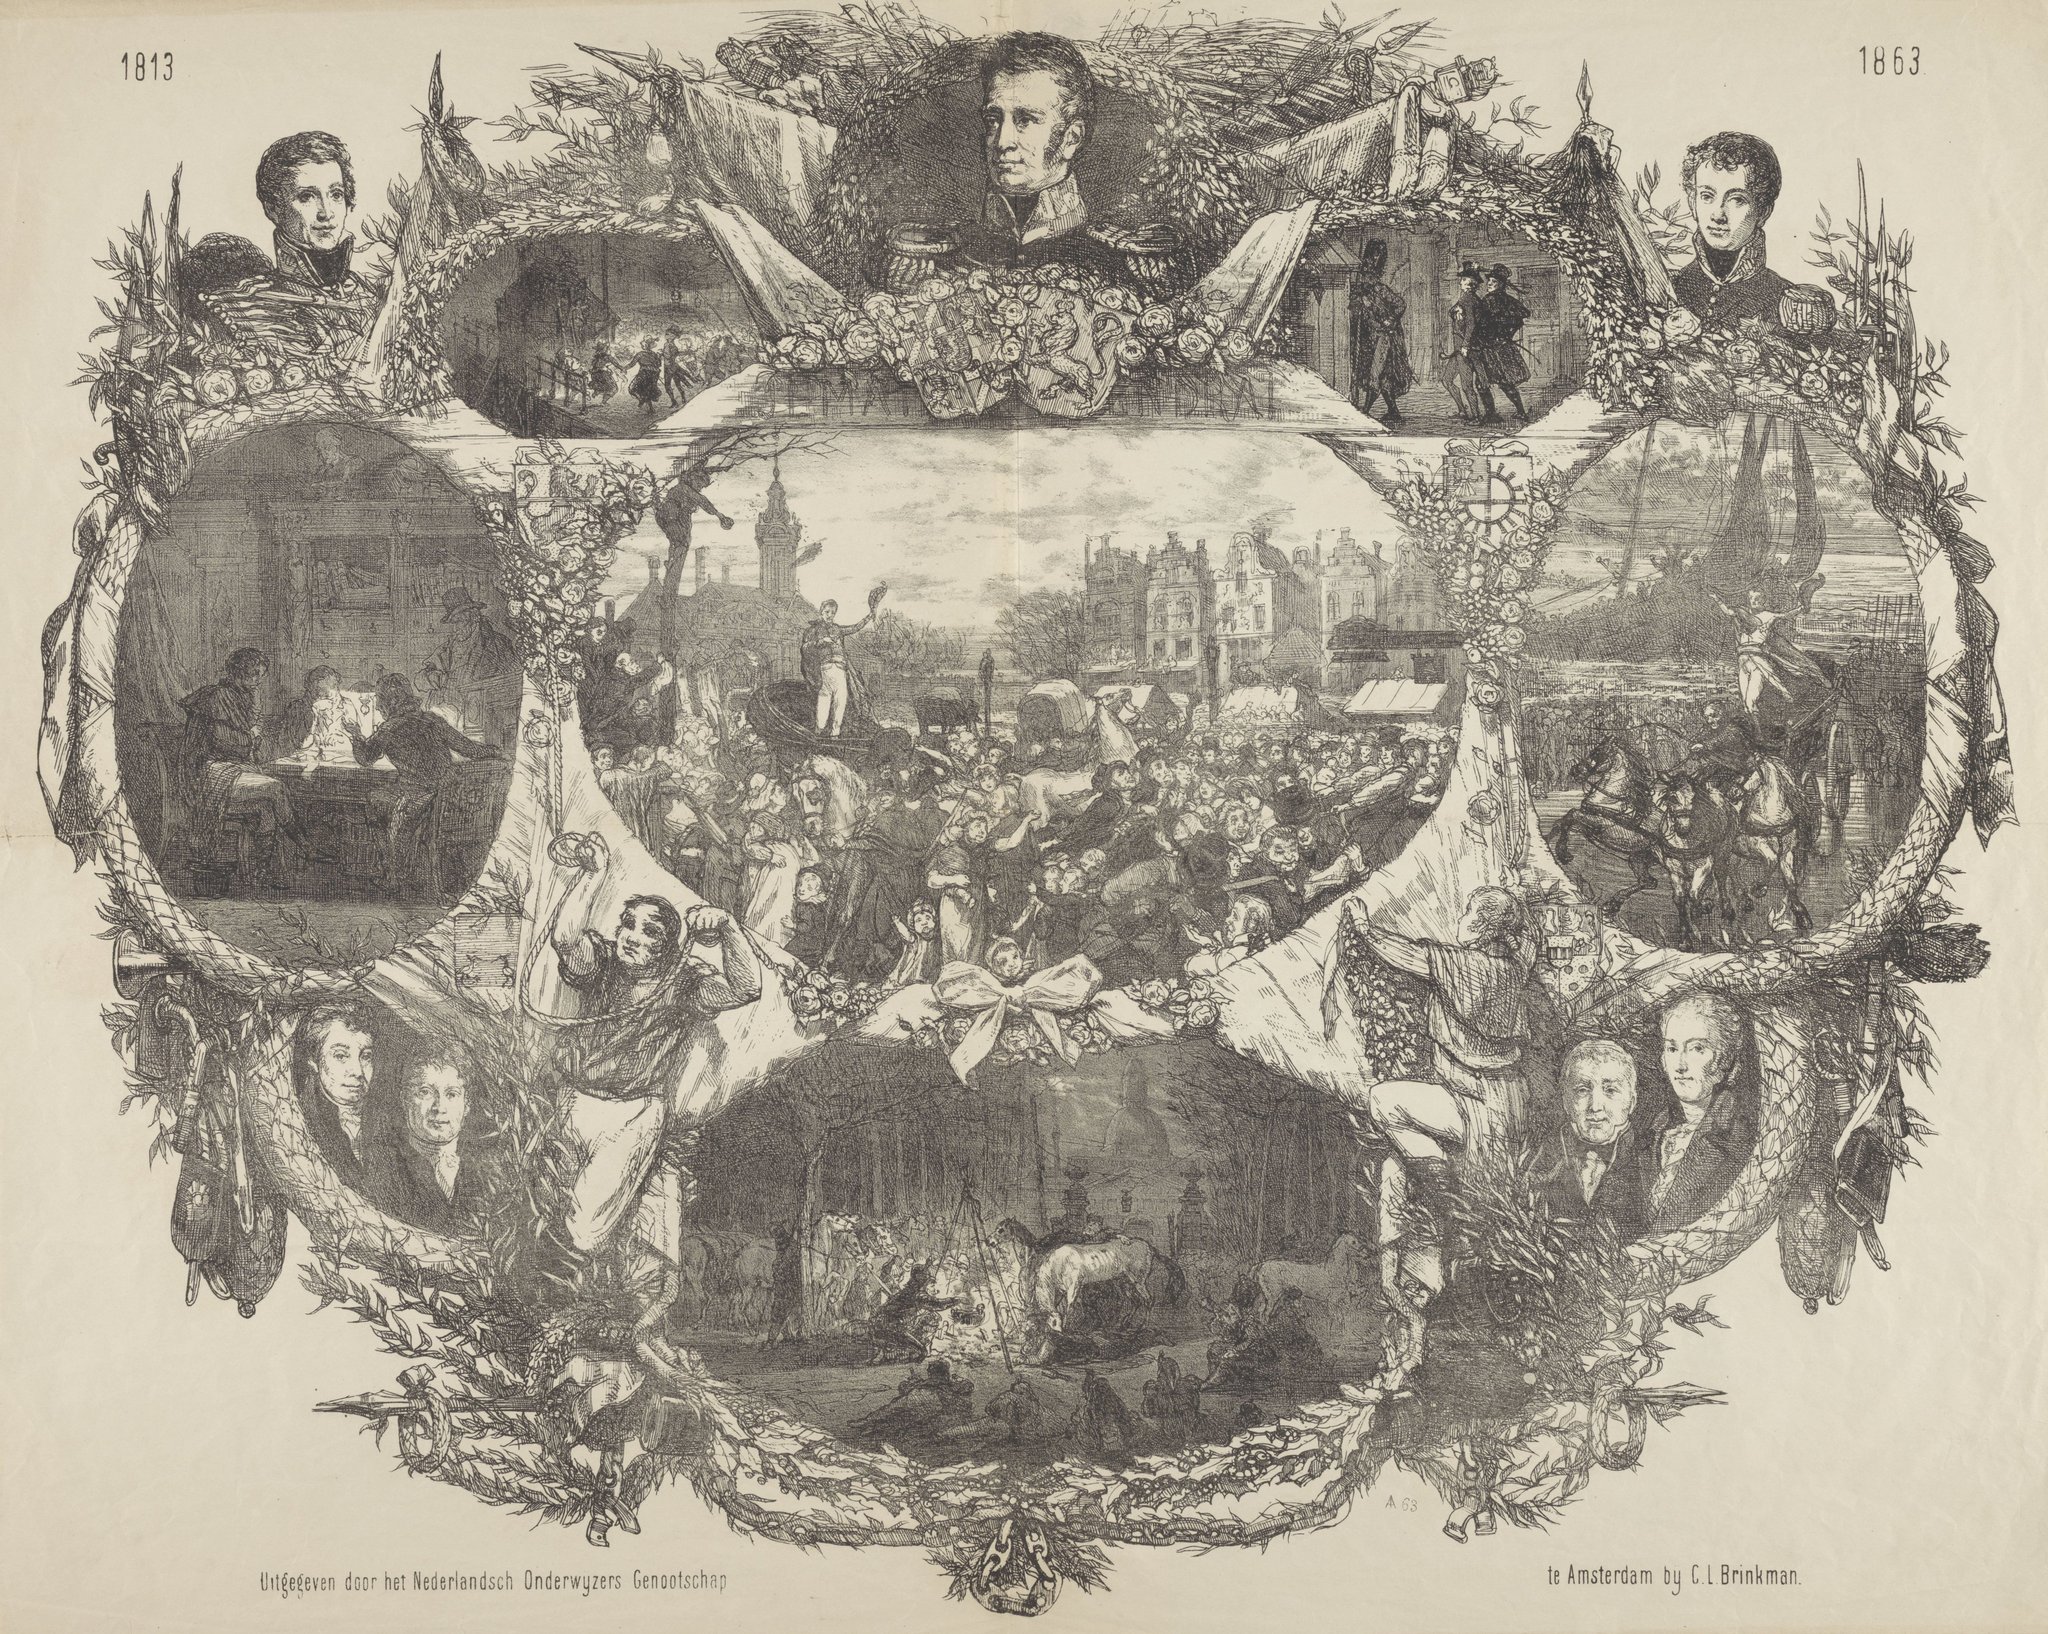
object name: print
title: Gedenkprent ter gelegenheid van 50 jaar Nederlandse onafhankelijkheid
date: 1863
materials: paper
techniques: lithograph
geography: amsterdam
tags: william i of the netherlands, rotterdam, gijsbert karel graaf van hogendorp, deventer, the hague, adam françois jules armand van der duyn, napoleon i (emperor of the french), other festivities connected to calendar dates; memorial days, liberation, landing of william frederick i (1813)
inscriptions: collector's mark: Lugt 2760, collector's mark: Lugt 2166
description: De gebeurtenissen in guirlandes hebben betrekking op de terugkeer van Willem I Frederik, prins van Oranje, naar Nederland in 1813. Links komen Van Hogendorp en andere regenten samen om de terugkeer van Willem I vanuit Engeland te bespreken. Rechts arriveert Willem I op het stand in Scheveningen. Bovenin is het portret van koning Willem I omgeven door vlaggen, banieren en wapenschilden. Onderin kamperen Russische soldaten die de Nederlandse troepen te hulp kwamen. In het midden de aankomst van de nieuwe koning in Amsterdam op het Haarlemmerplein.